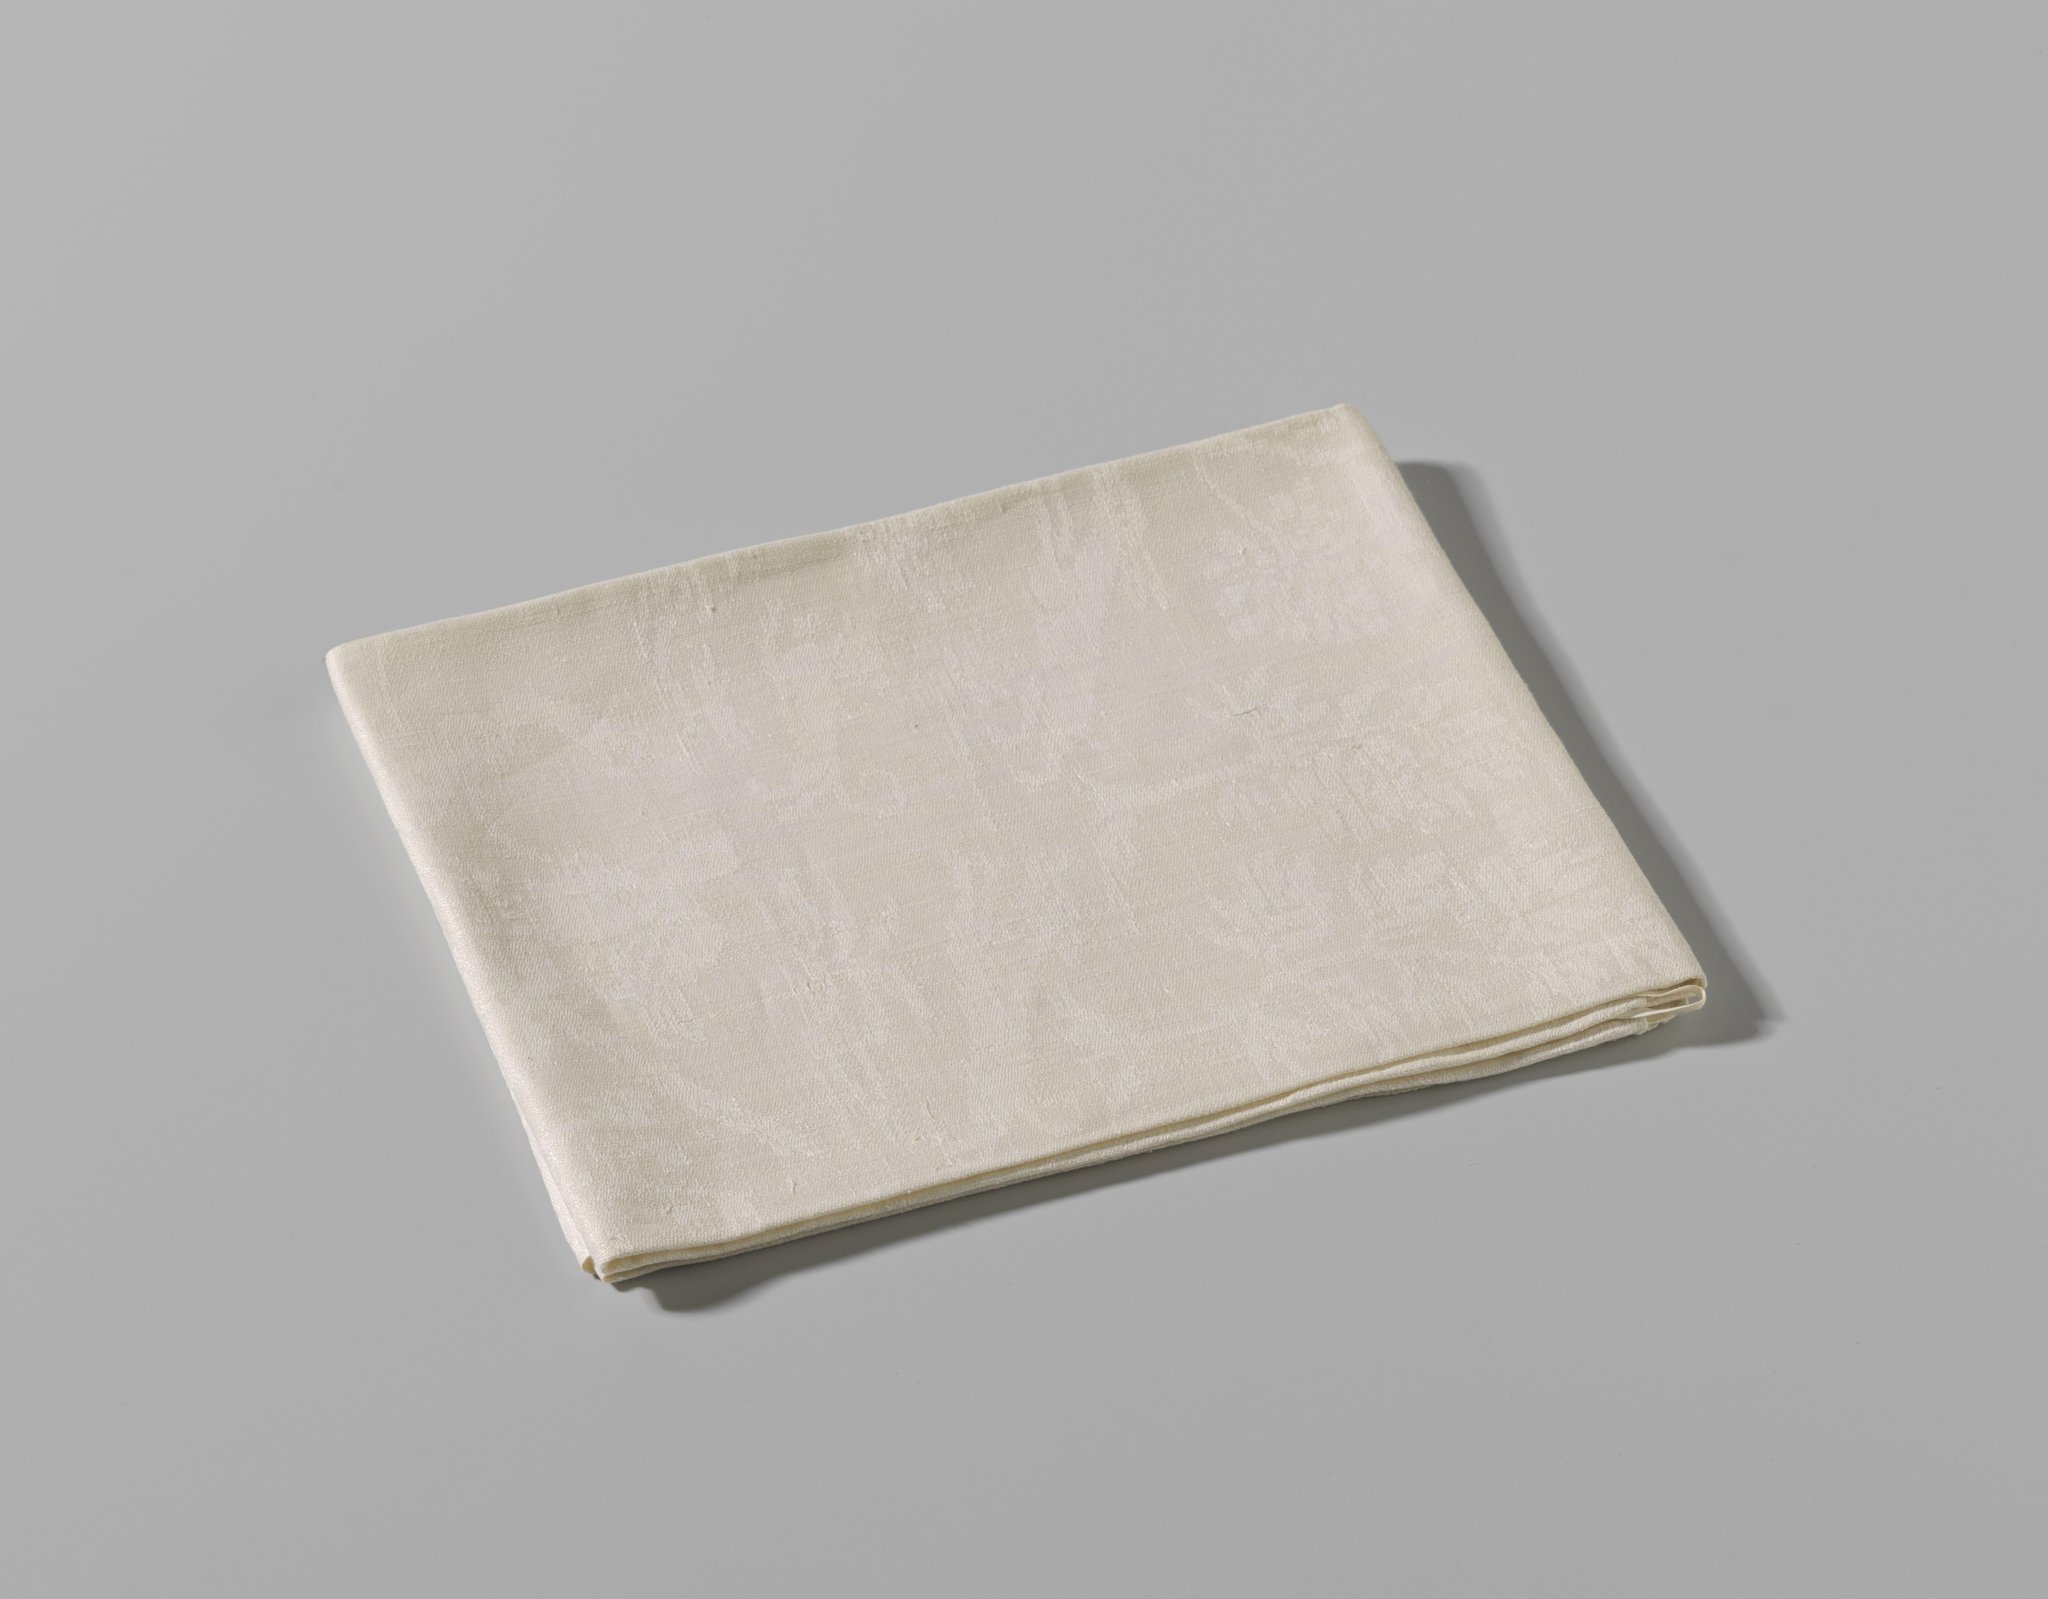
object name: napkin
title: Servet met een jachttafereel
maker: Anonymous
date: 1650-1699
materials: linen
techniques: damask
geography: southern netherlands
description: Servet van linnendamast met een jachttafereel. Middenveld: het symmetrisch patroon vertoont twee taferelen: 1 Een hoor blazende en musket dragende jager loopt van het midden naar de zijkant. Hij is gekleed in justaucorps, lage schoenen en breedgerande hoed. Voor hem een weglopende hond. Er boven, tussen de bomen, een meute honden die een haas achtervolgen. 2 Van de zijkant loopt een jager, in dito kledij, naar het midden. Hij heeft een musket in de aanslag en volgt de honden die een hert omsingelen. Staande en liggende randen, door een lijn gescheiden van het middenveld: symmetrische voluutranken, versierd met geblokte binnentekening; daarbuiten smalle blokkenrand.